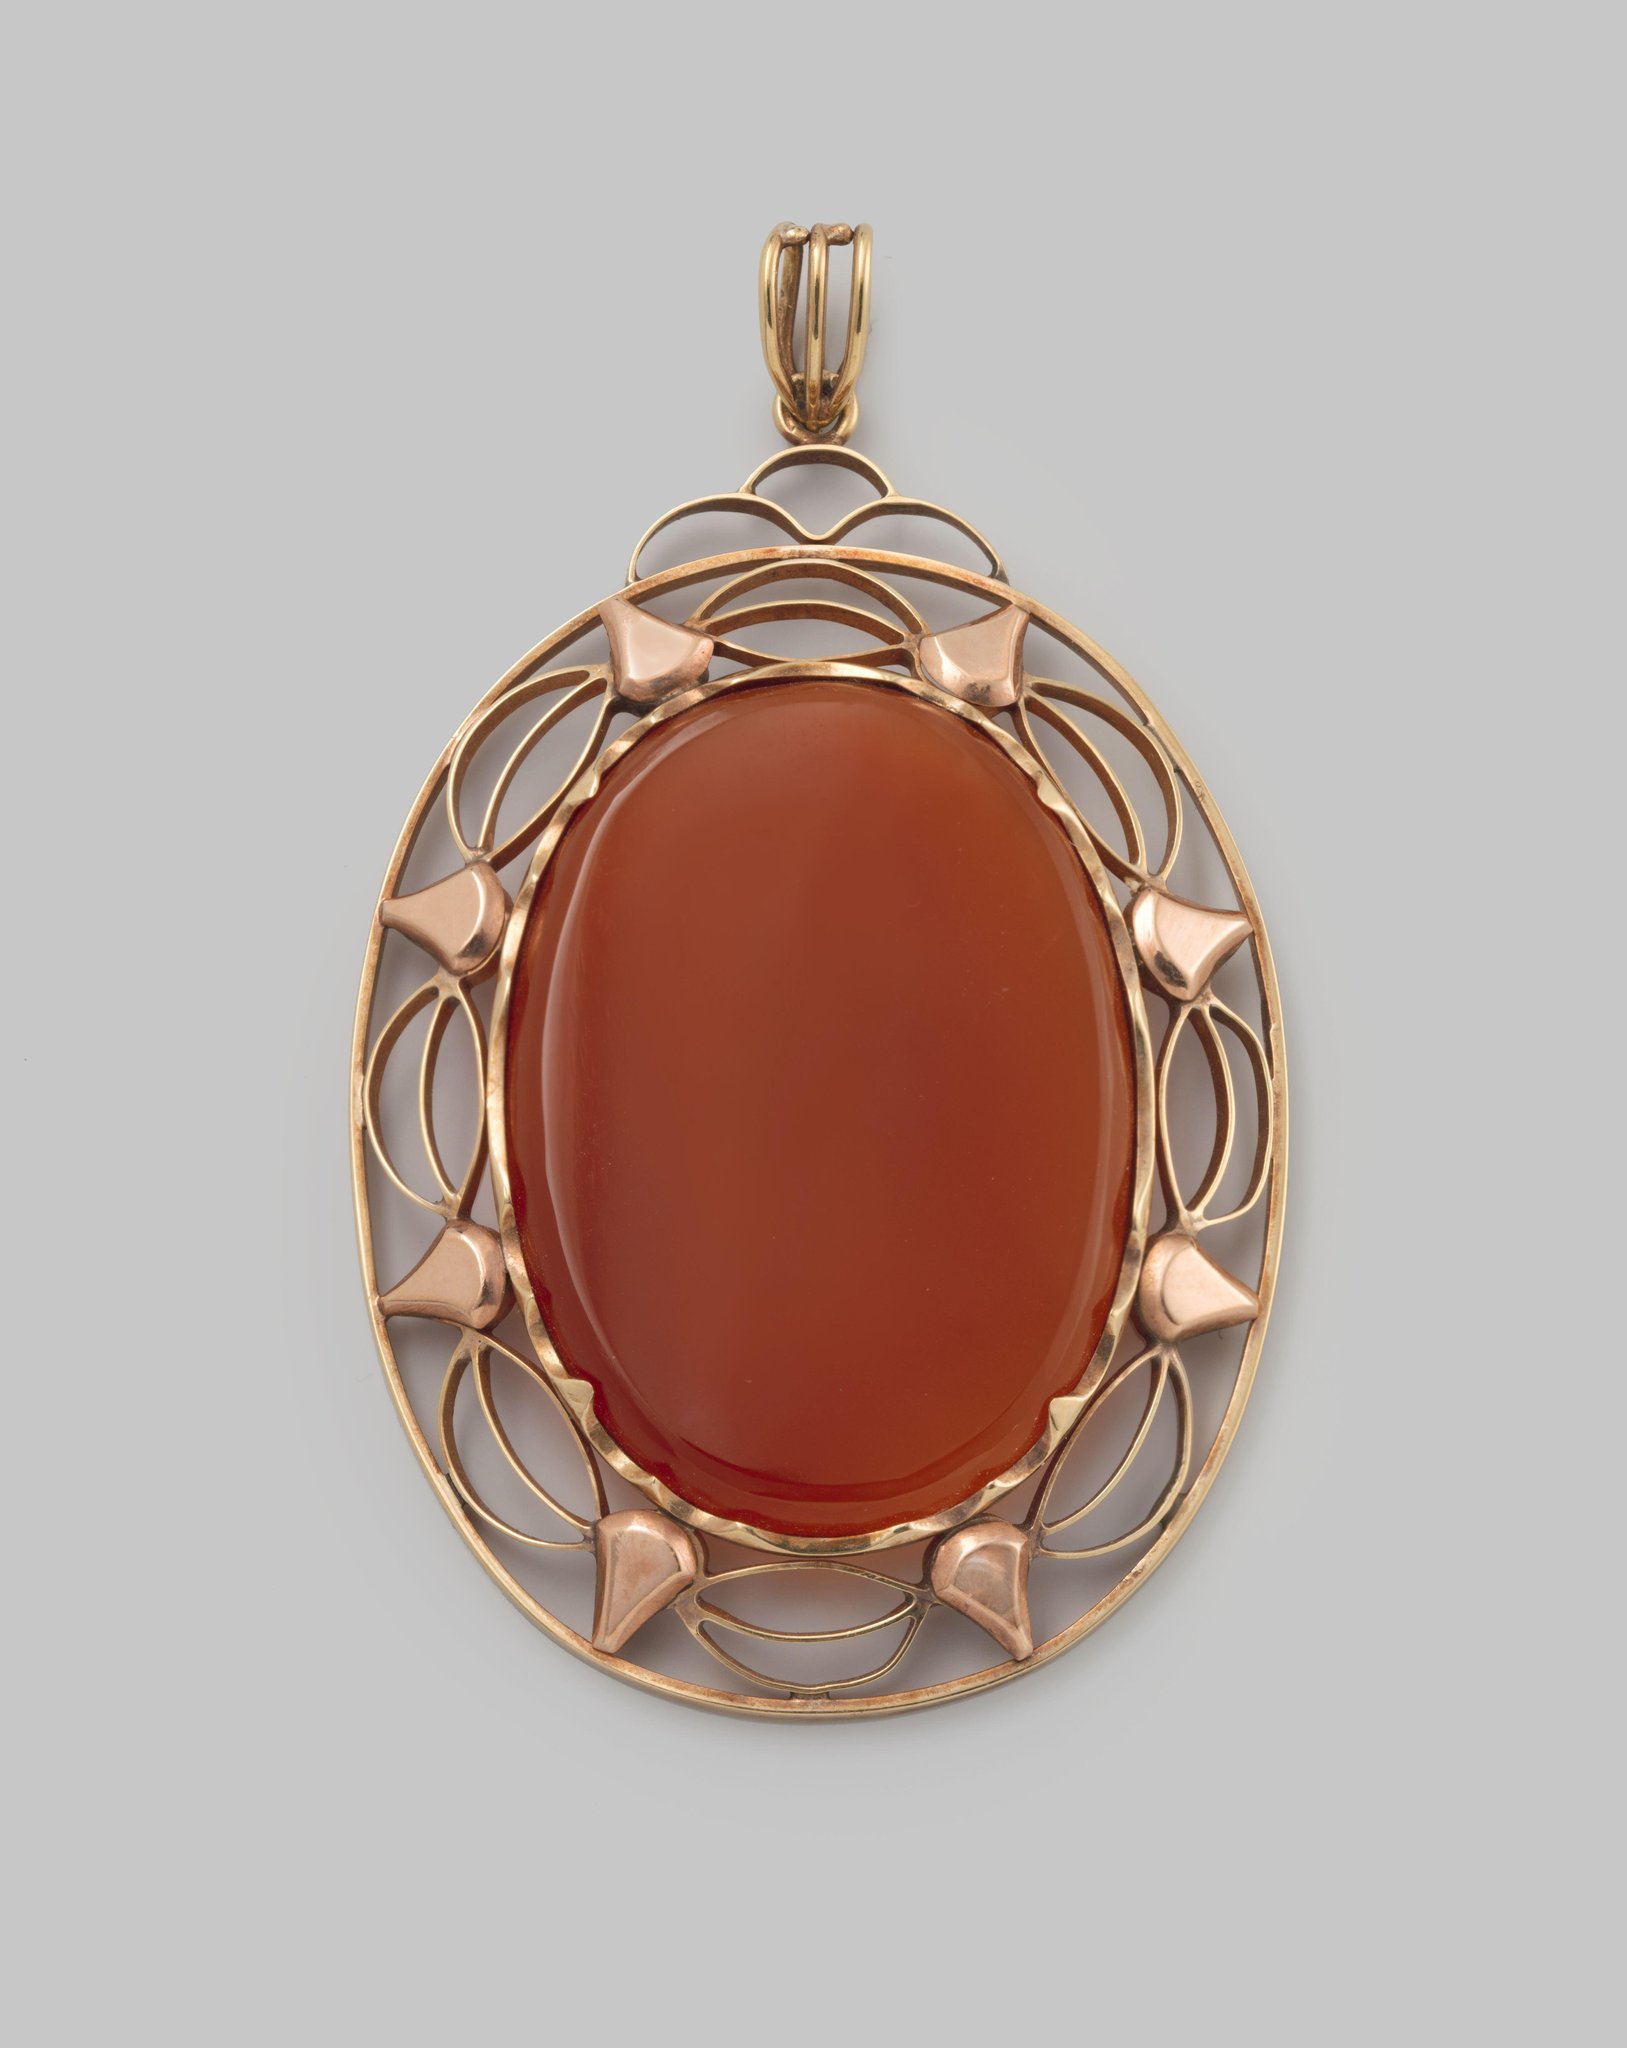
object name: pendant jewelry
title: Ovale hanger van goud in twee kleuren met carneool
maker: Anonymous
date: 1930-1950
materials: gemstone, gold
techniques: forging, grinding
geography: netherlands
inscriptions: alloy mark: ‘(oud) eikenblad’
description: Ovale hanger van handgesmeed goud in twee kleuren (rood en geel) met ovale cabochon geslepen carneool voorzien van een ajour draadoog die bestaat uit drie draden.